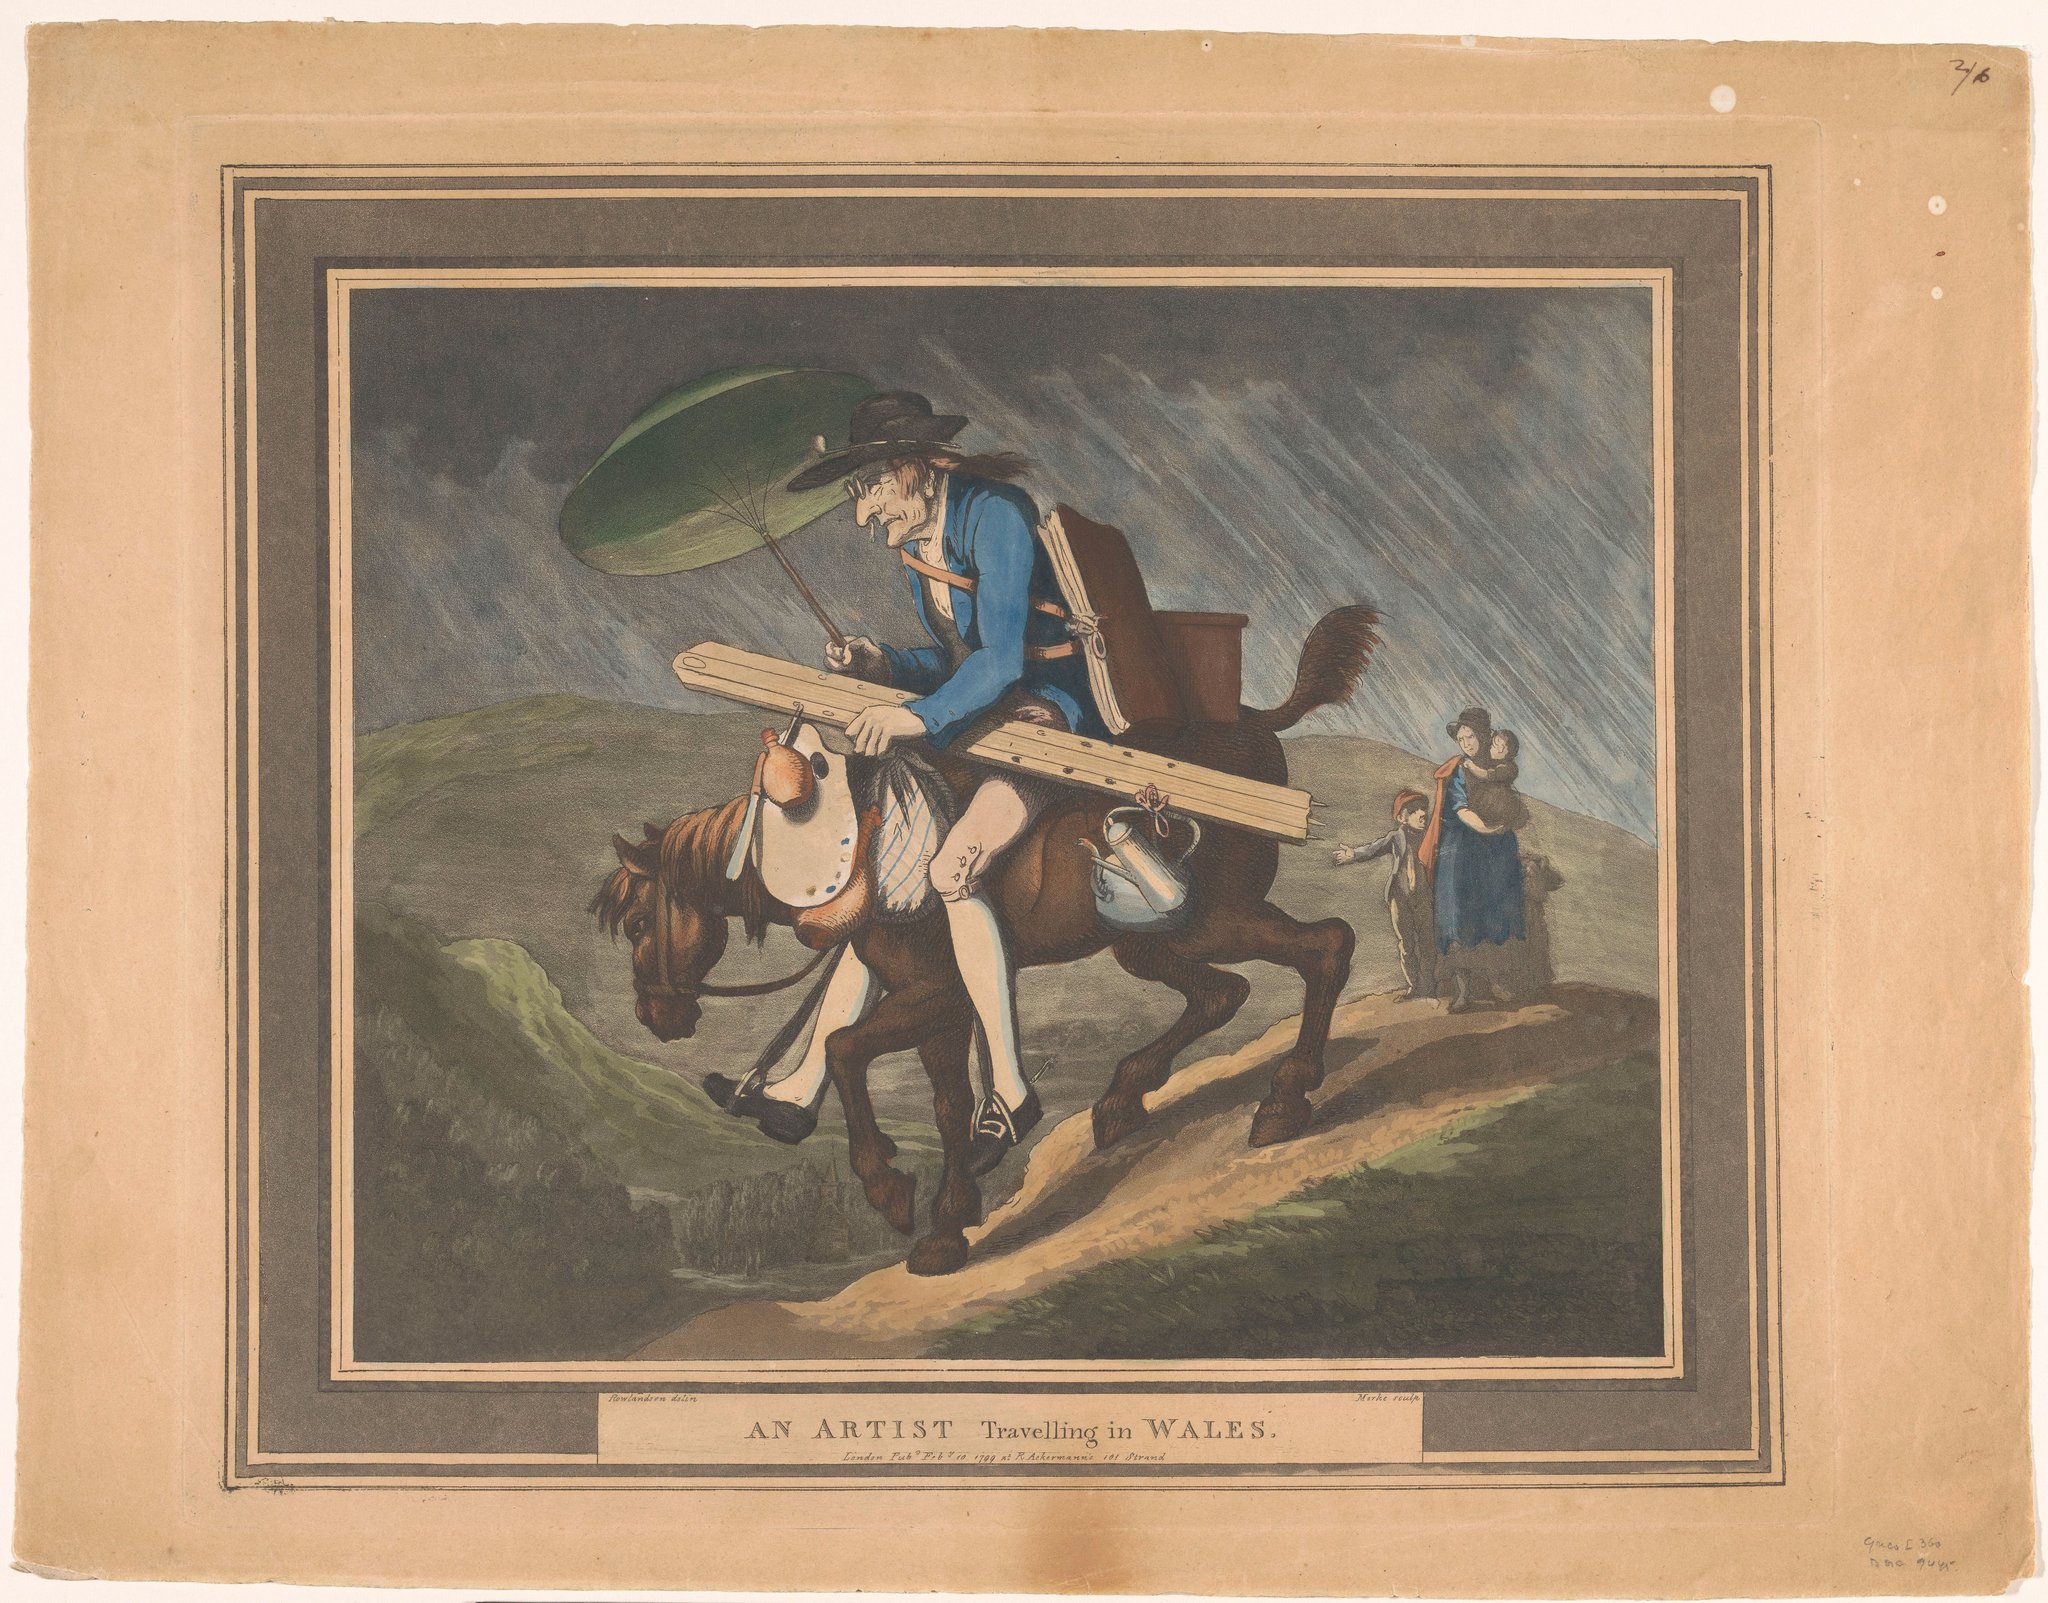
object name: print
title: An artist travelling in Wales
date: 1702-1799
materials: paper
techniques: aquatint, etching, hand coloring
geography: london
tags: painter, print maker, draughtsman, henry wigstead, riding a horse, ass, or mule; rider, horseman, tools, implements of painter, rain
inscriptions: collector's mark: Lugt 4779, collector's mark: Lugt 2228, watermark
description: In een regenachtig landschap zit een man met een paraplu op een paard beladen met schilders gereedschappen. De man heeft een pijp in zijn hoed en er hangt een druppel aan zijn neus. In de achtergrond een vrouw met kinderen.